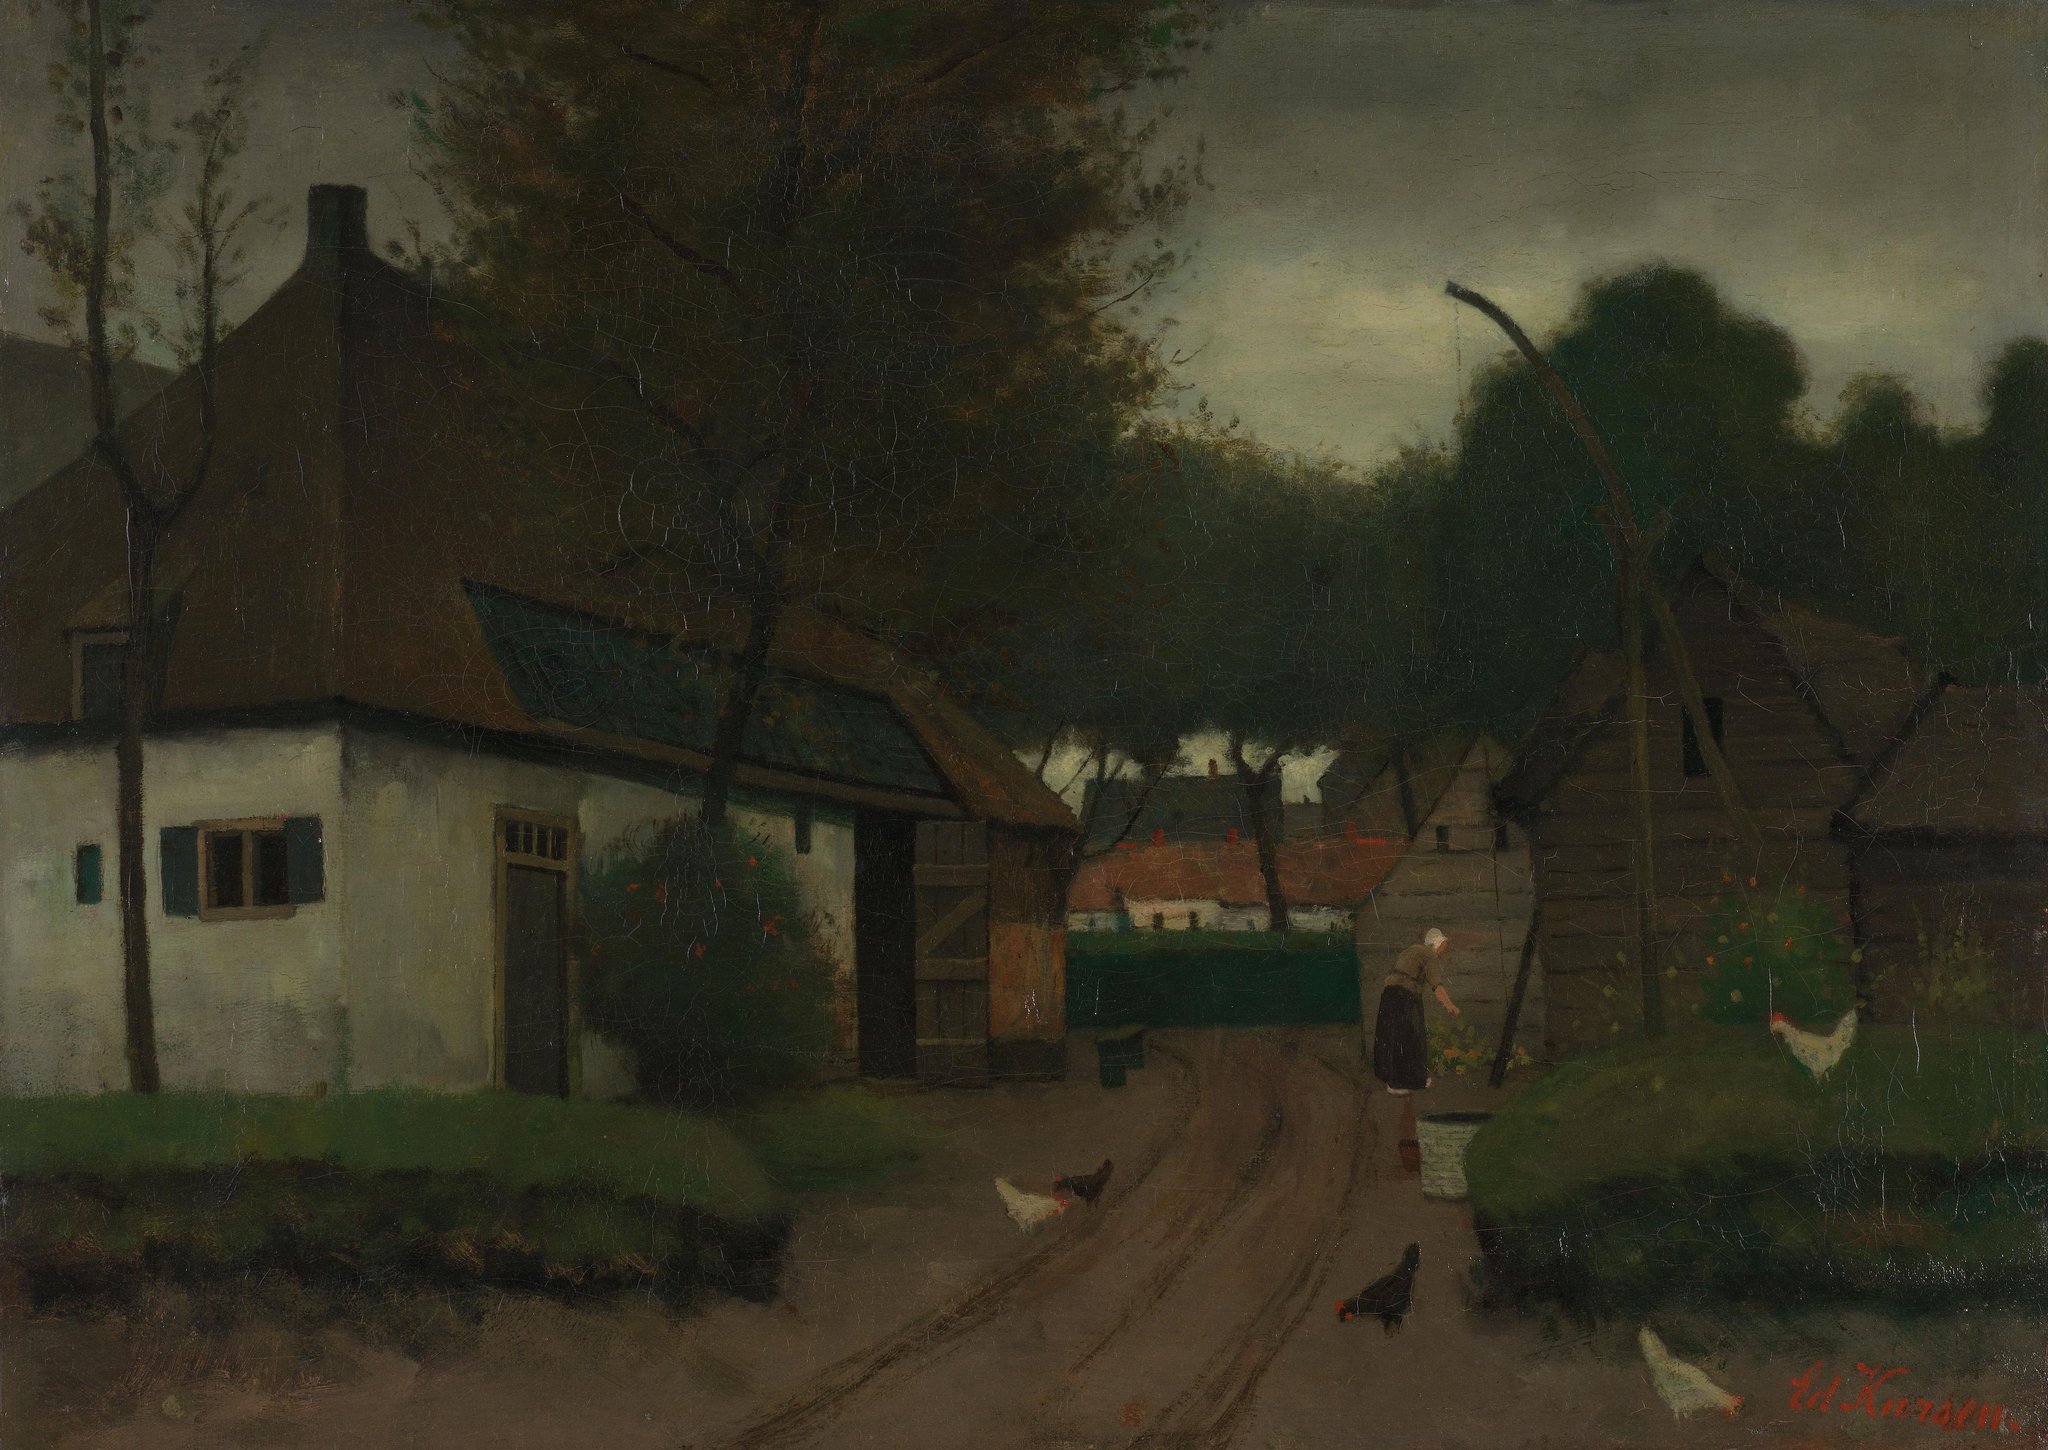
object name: painting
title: Farmstead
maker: eduard karsen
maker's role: draughtsman, painter, print maker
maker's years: 1860-1941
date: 1890-1900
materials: canvas, oil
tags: canals, waters (in village), farm (building)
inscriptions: signature: ‘Ed. Karsen’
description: Boerenhofstede. Kippen scharrelen over het erf, voorbij de waterput staat een boerin. Op de achtergrond staan huizen van een dorp.